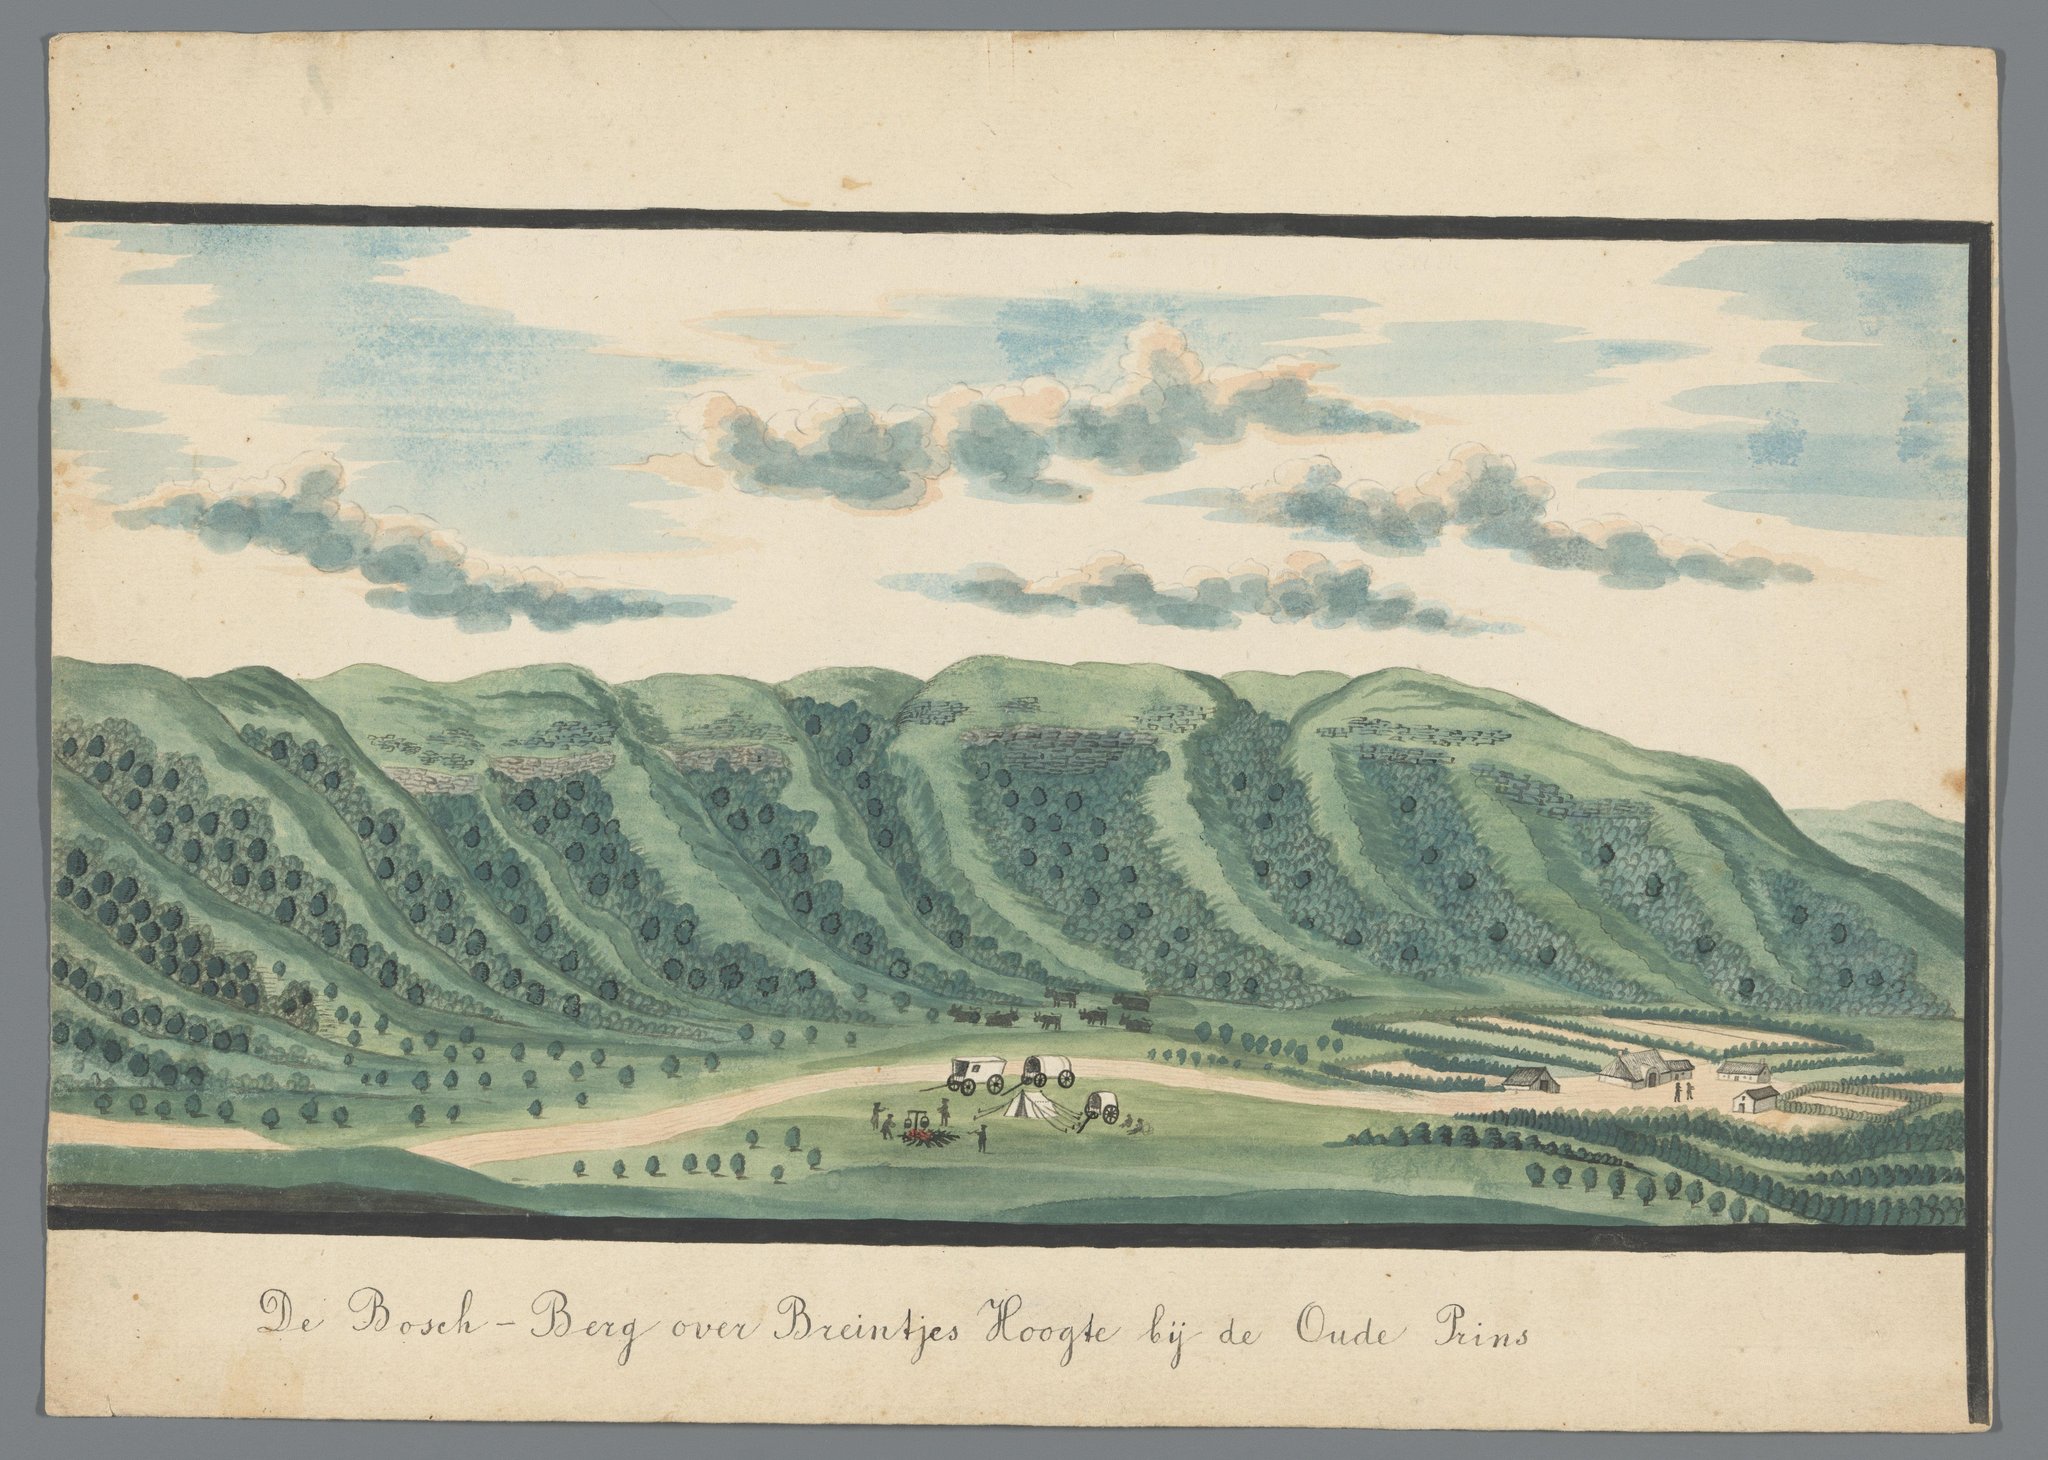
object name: drawing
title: De Bosch-Berg over Breintjes Hoogte bij de Oude Prins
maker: johannes schumacher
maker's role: draughtsman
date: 1710-1776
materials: paper, watercolor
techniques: brush, pen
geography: south africa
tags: cape of good hope, covered wagon, hooded wagon, mountain-range, snow peaks, farm or solitary house in landscape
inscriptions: label: ‘32’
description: Rechterhelft van een panorama over de Bosberg en de Groot Bruintjieshoogte. Op de voorgrond een bivak van enkele wagens. Rechts de boerderij van Prinsloo Senior. Tekening gemaakt tijdens de tweede reis van Hendrik Swellengrebel, naar het noordoosten van de Kaapkolonie, 10 september - 26 december 1776. Volgens het reisjournaal verbleef het reisgezelschap hier 21-24 oktober 1776.